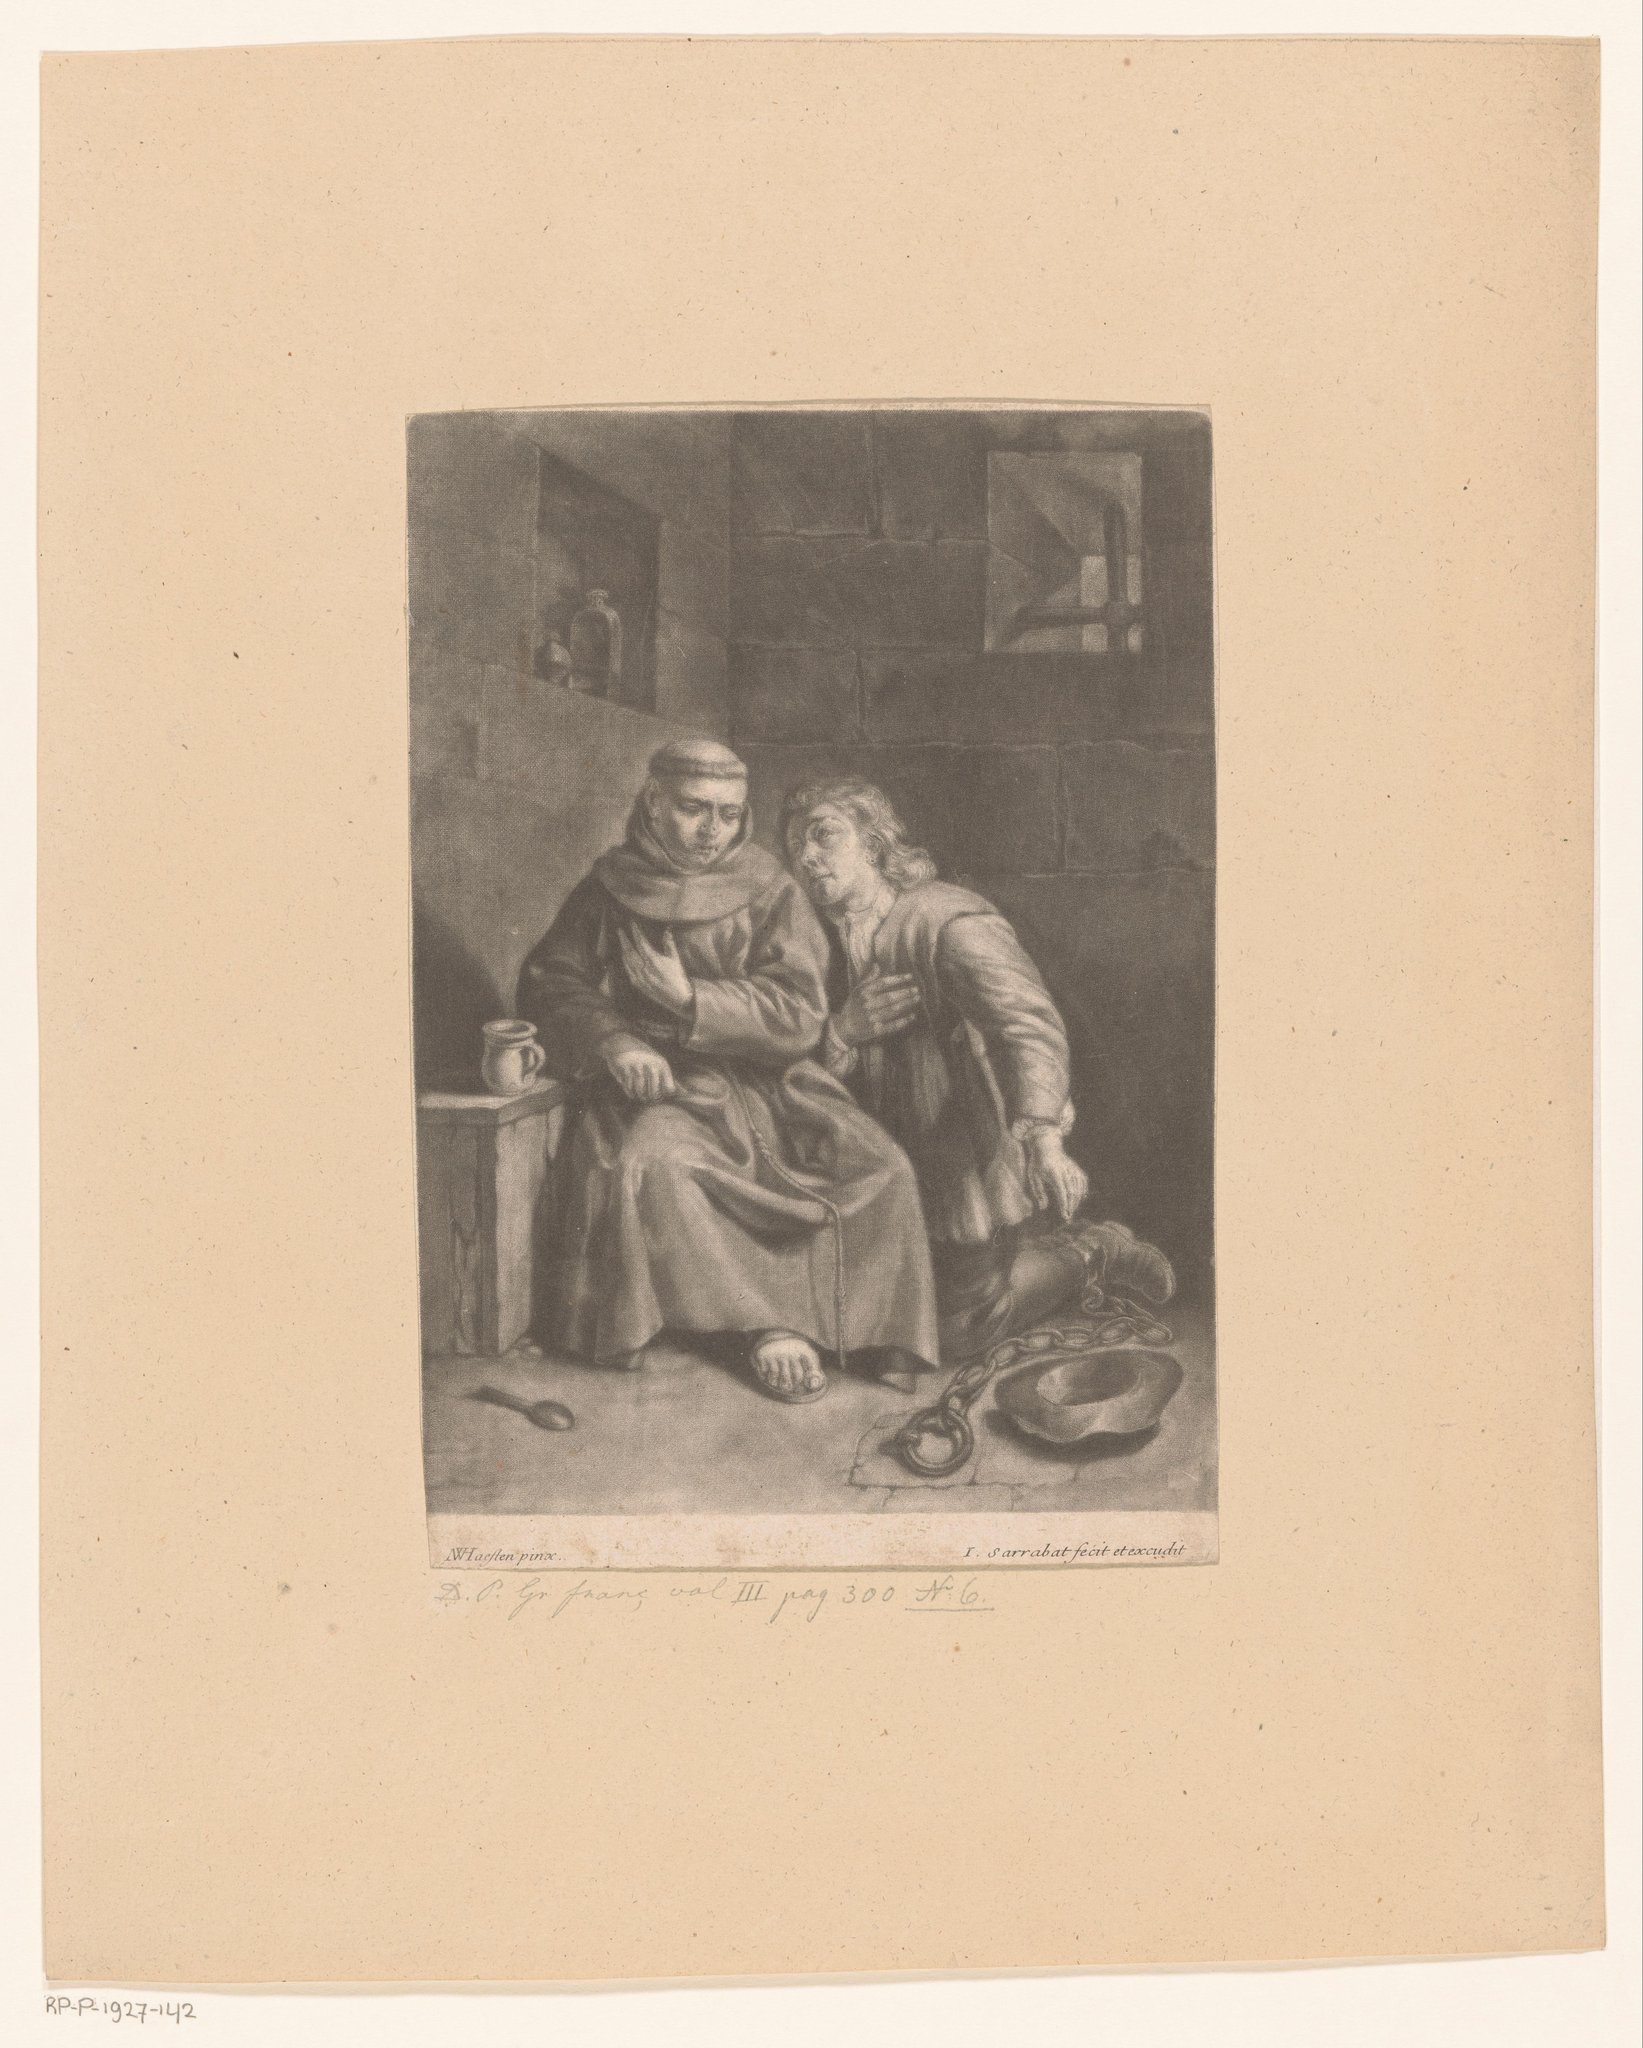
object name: print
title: Monnik neemt de biecht af van een gevangene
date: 1677-1701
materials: paper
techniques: mezzotint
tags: monk(s), friar(s), confession; 'confessione sacramentale' (ripa) ~ the third of the seven sacraments